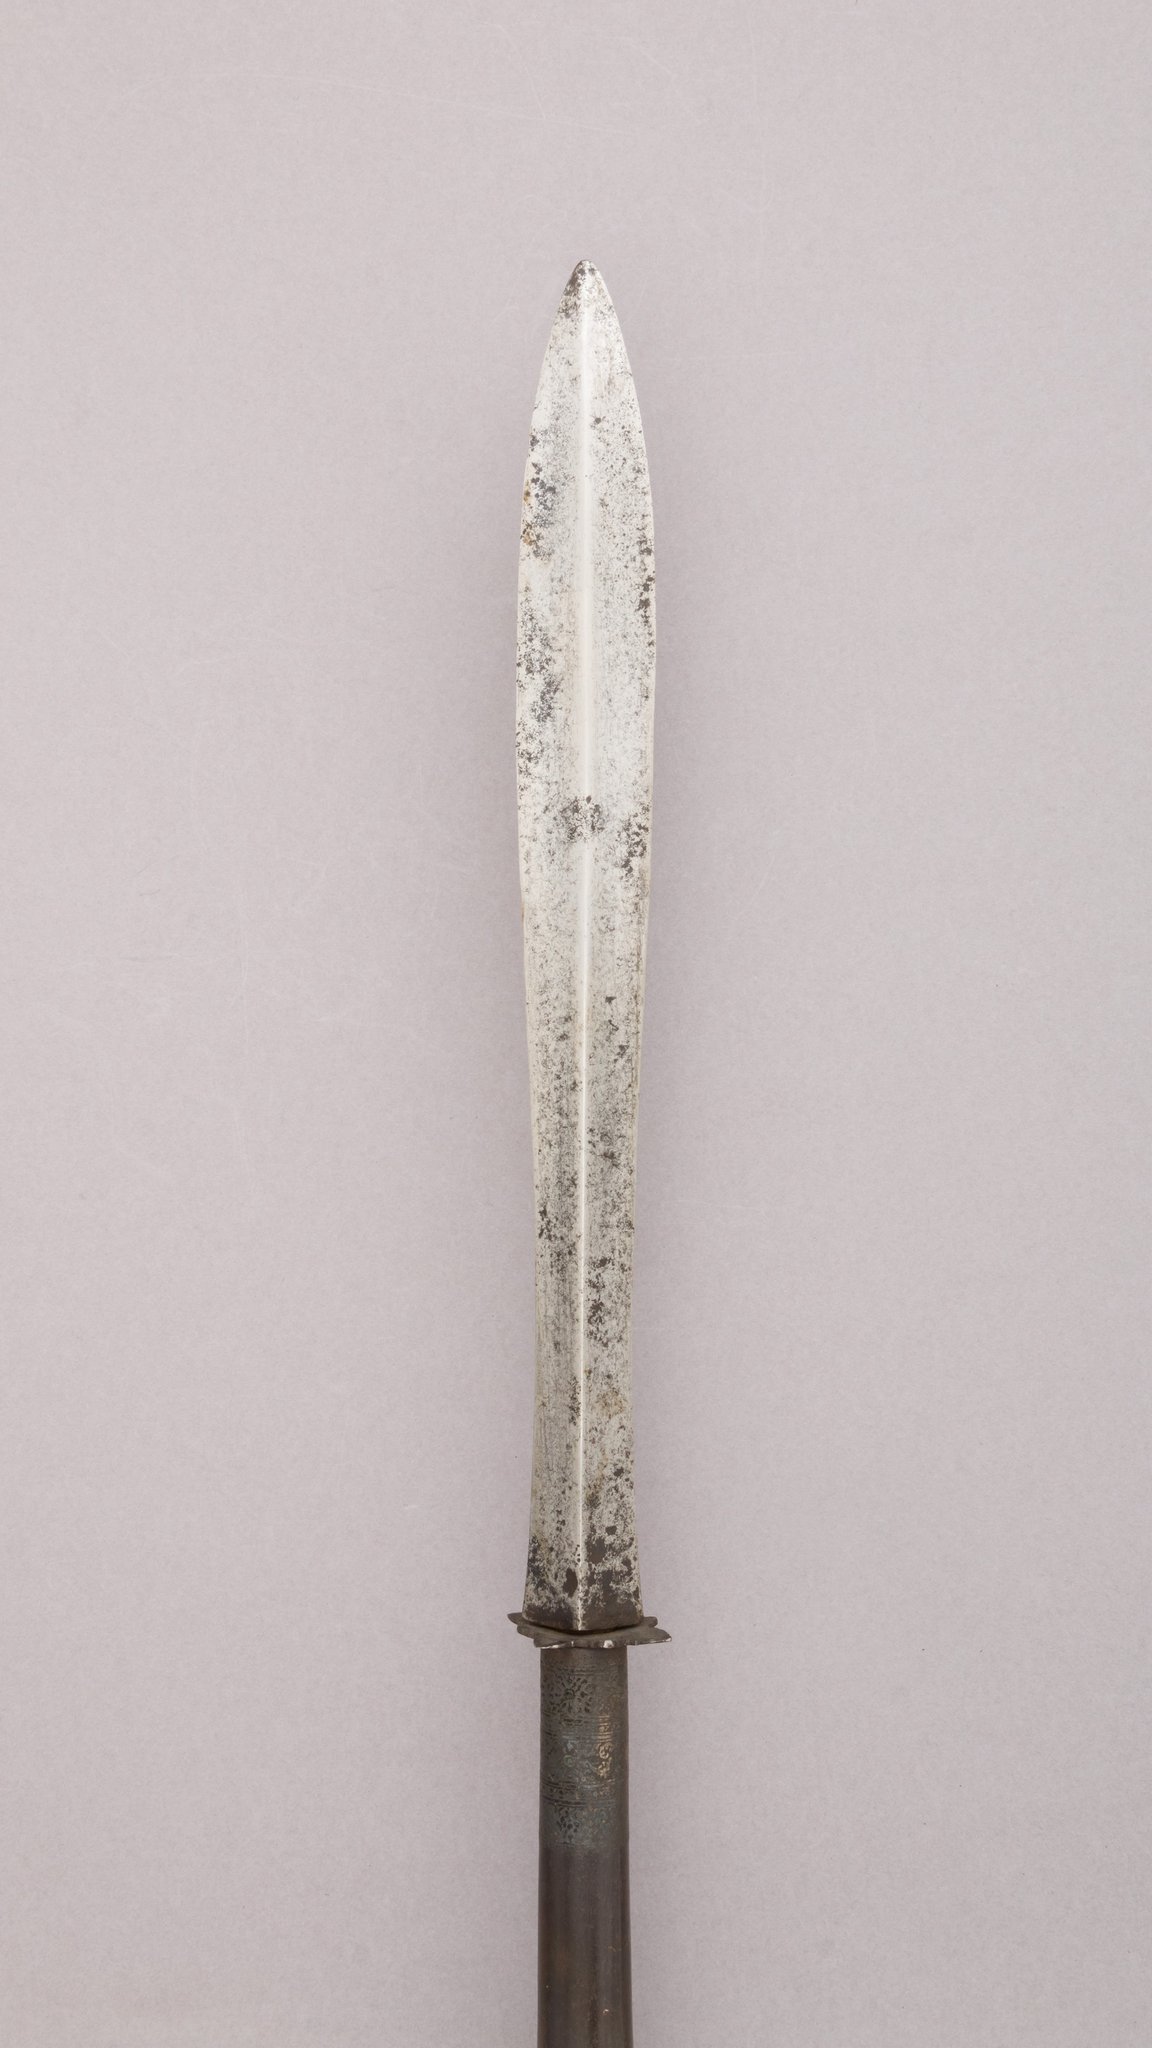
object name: spear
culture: thai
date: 1701-1900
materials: bamboo, silver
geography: thailand